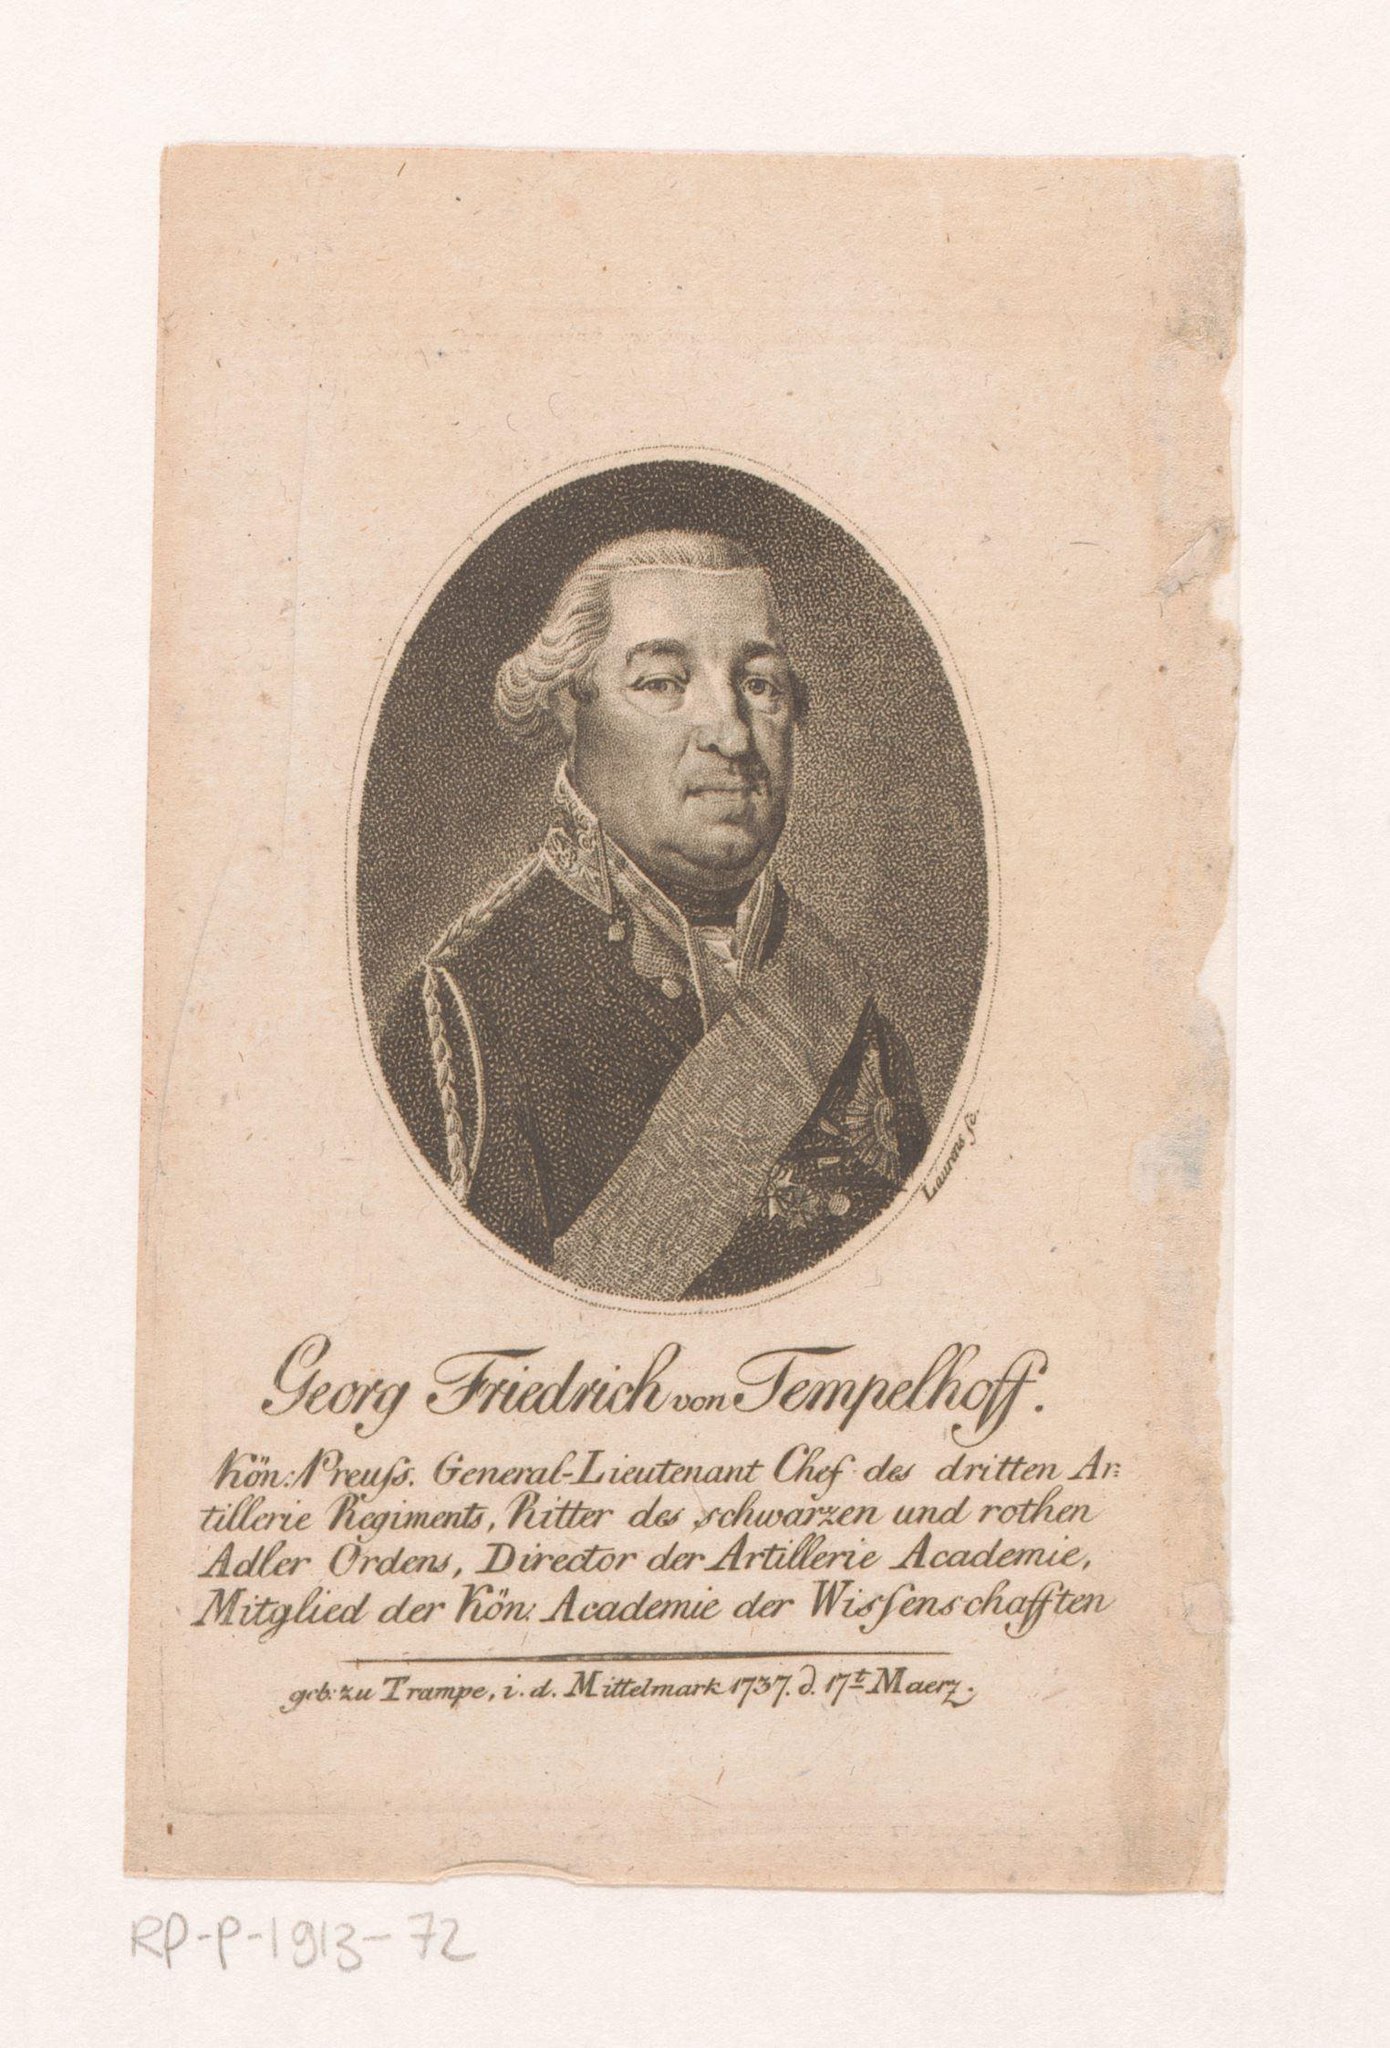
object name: print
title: Portret van Georg Friedrich von Tempelhoff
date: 1805-1806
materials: paper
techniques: etching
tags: berlin, historical persons, officer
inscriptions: collector's mark: Lugt 2228